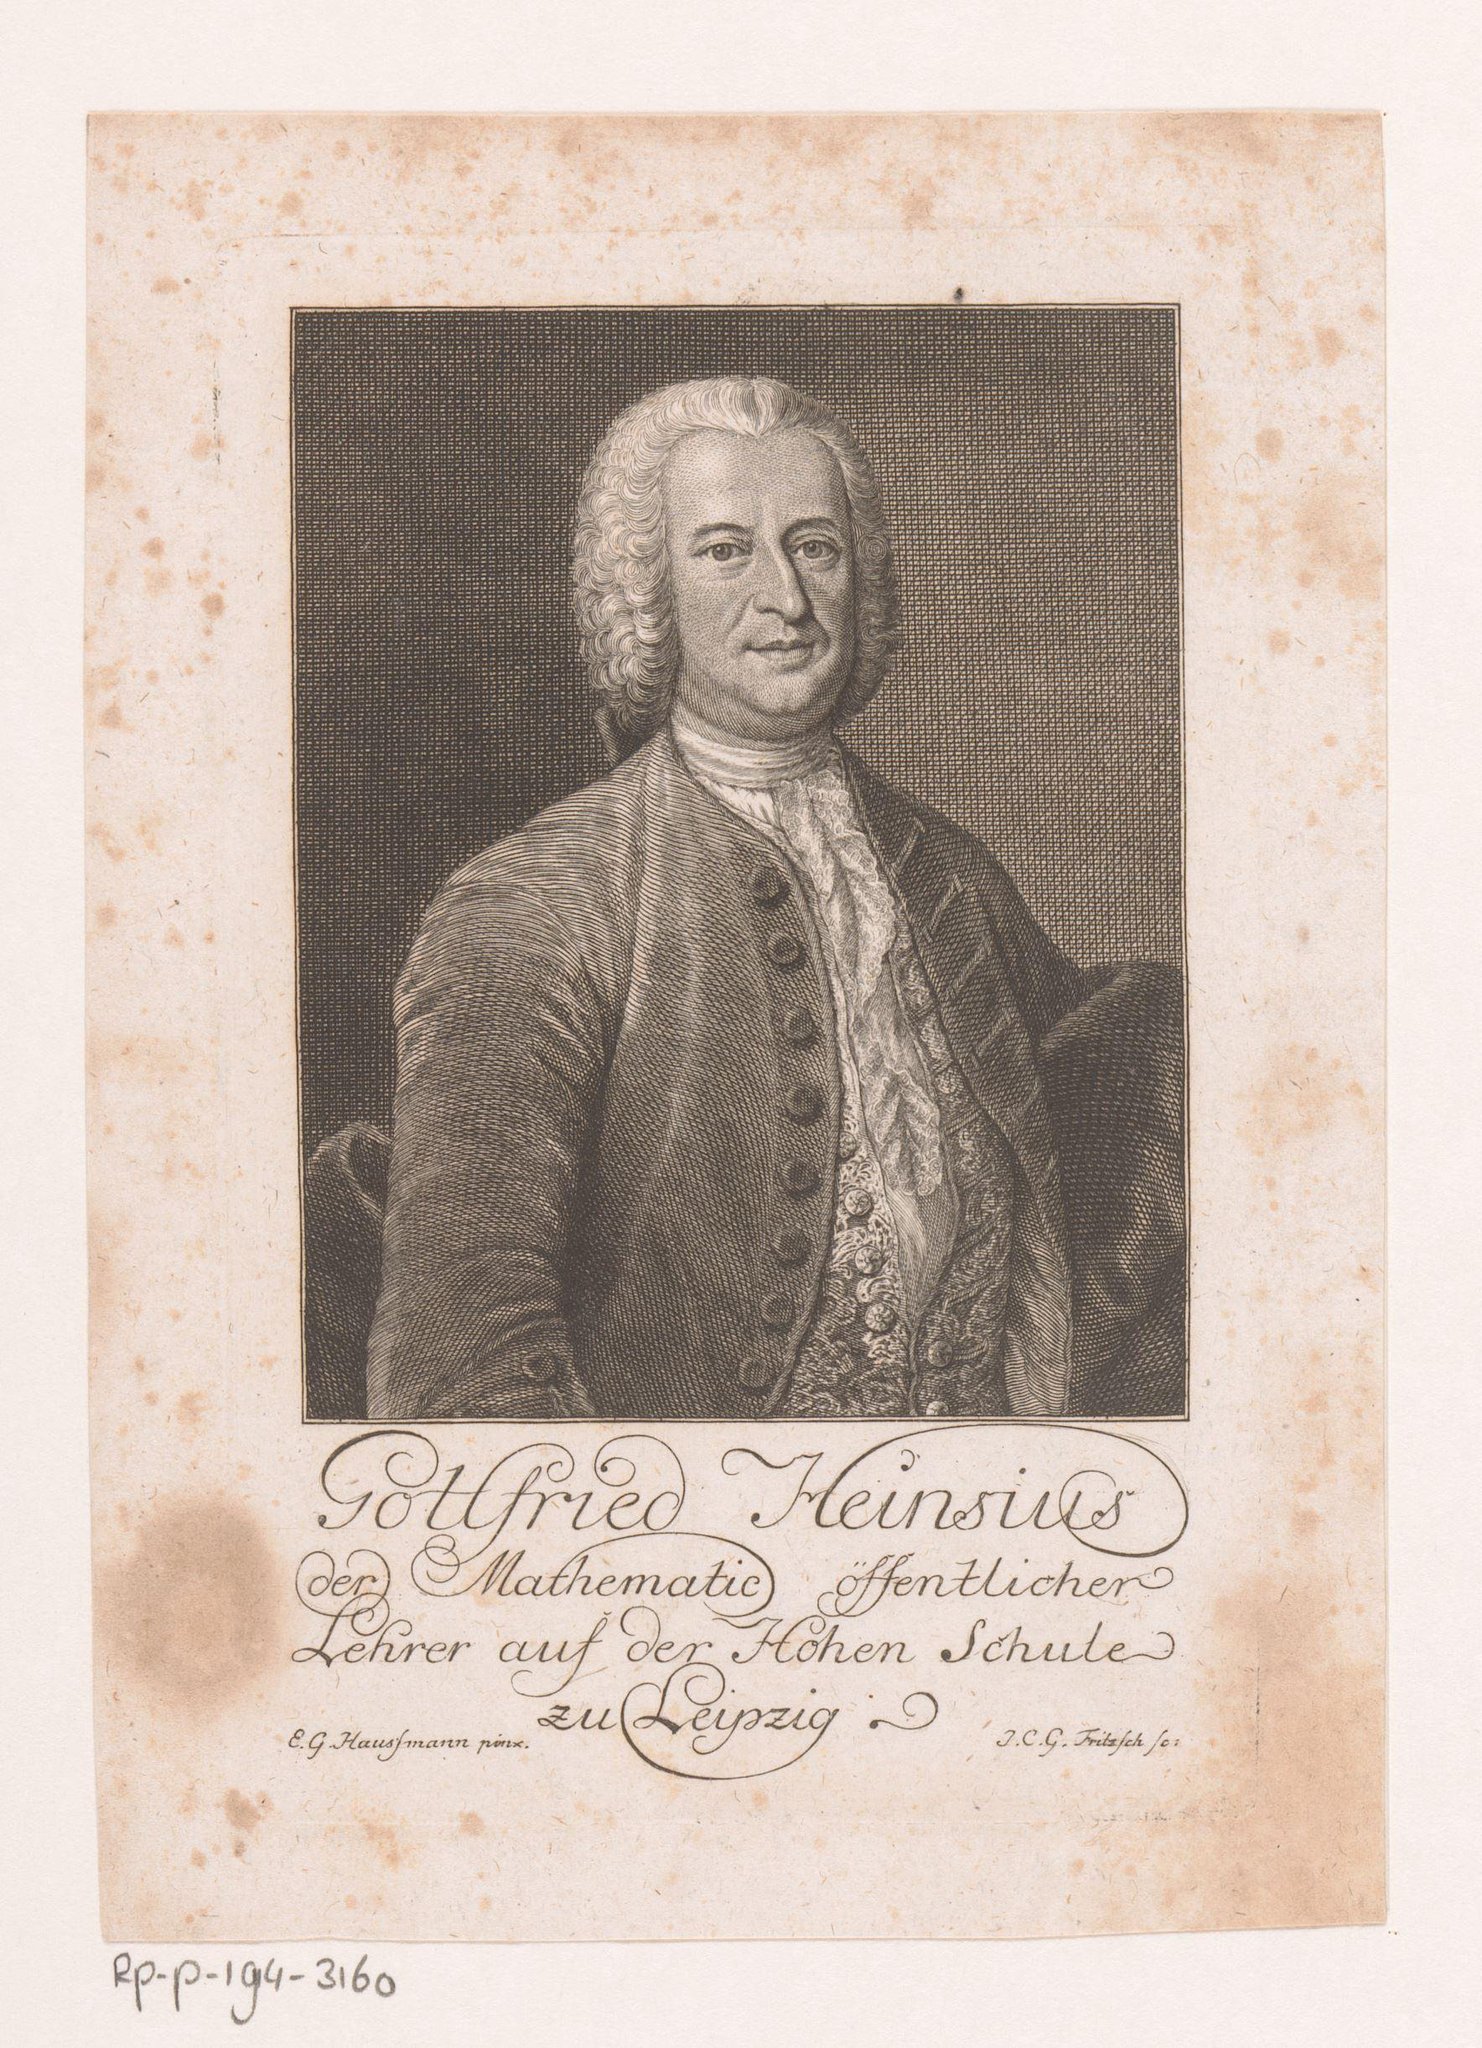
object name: print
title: Portret van Gottfried Heinsius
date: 1730-1803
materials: paper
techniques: engraving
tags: historical persons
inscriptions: collector's mark: Lugt 2228